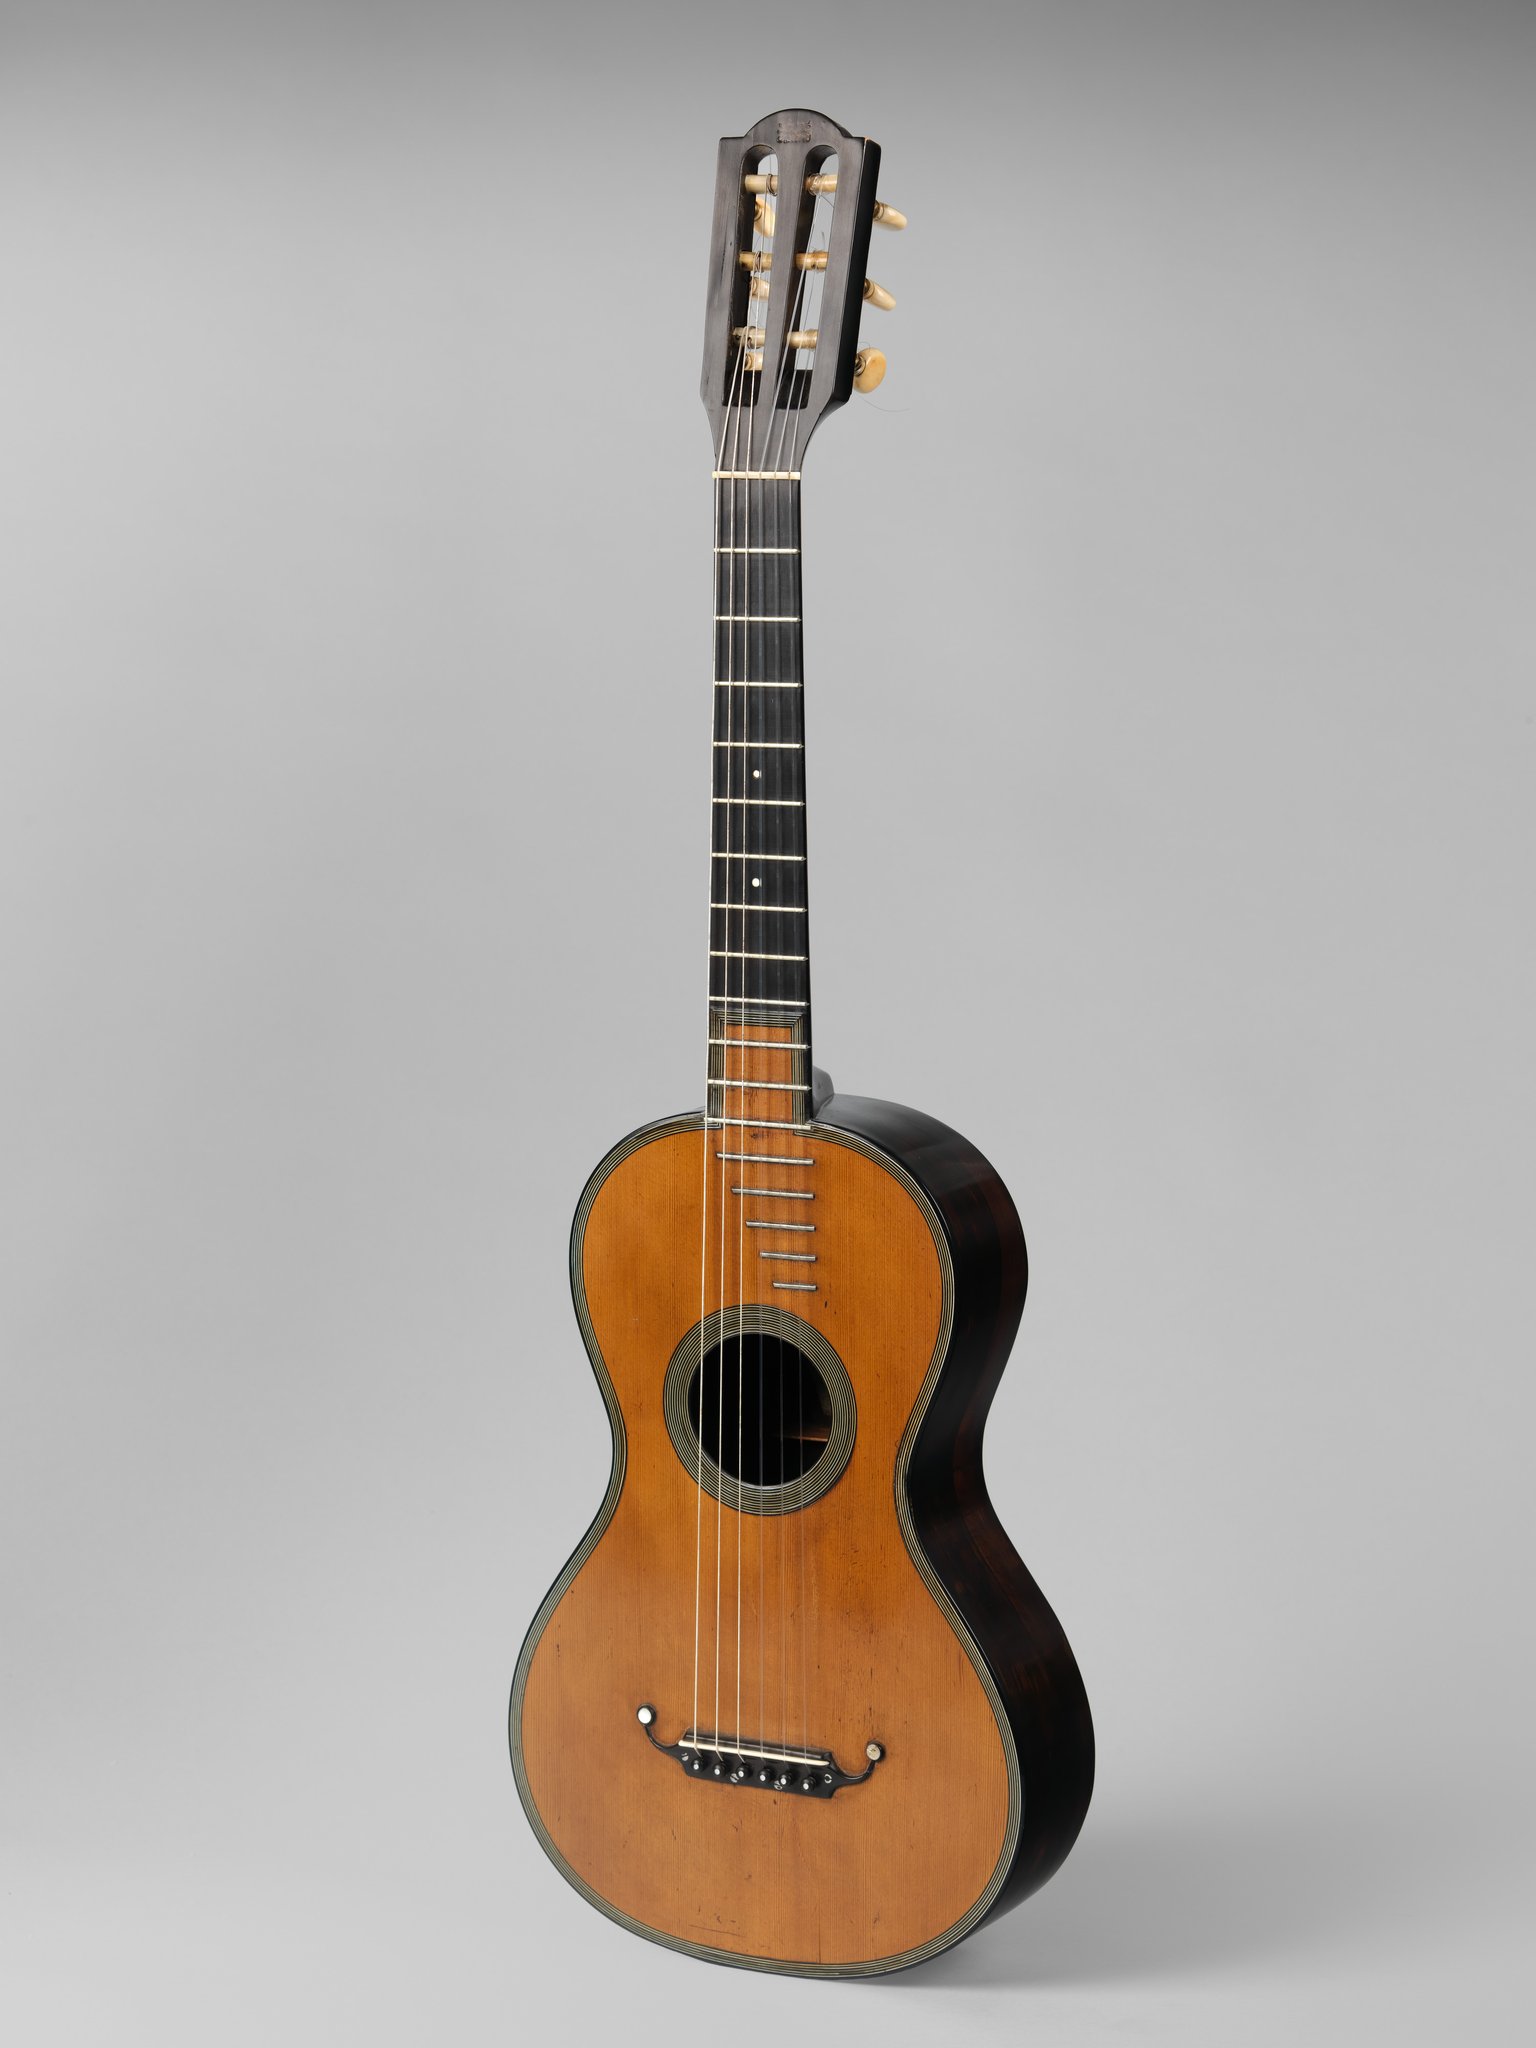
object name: guitar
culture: french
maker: pierre-rené lacôte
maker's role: maker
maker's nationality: french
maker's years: 1785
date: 1835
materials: wood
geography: france